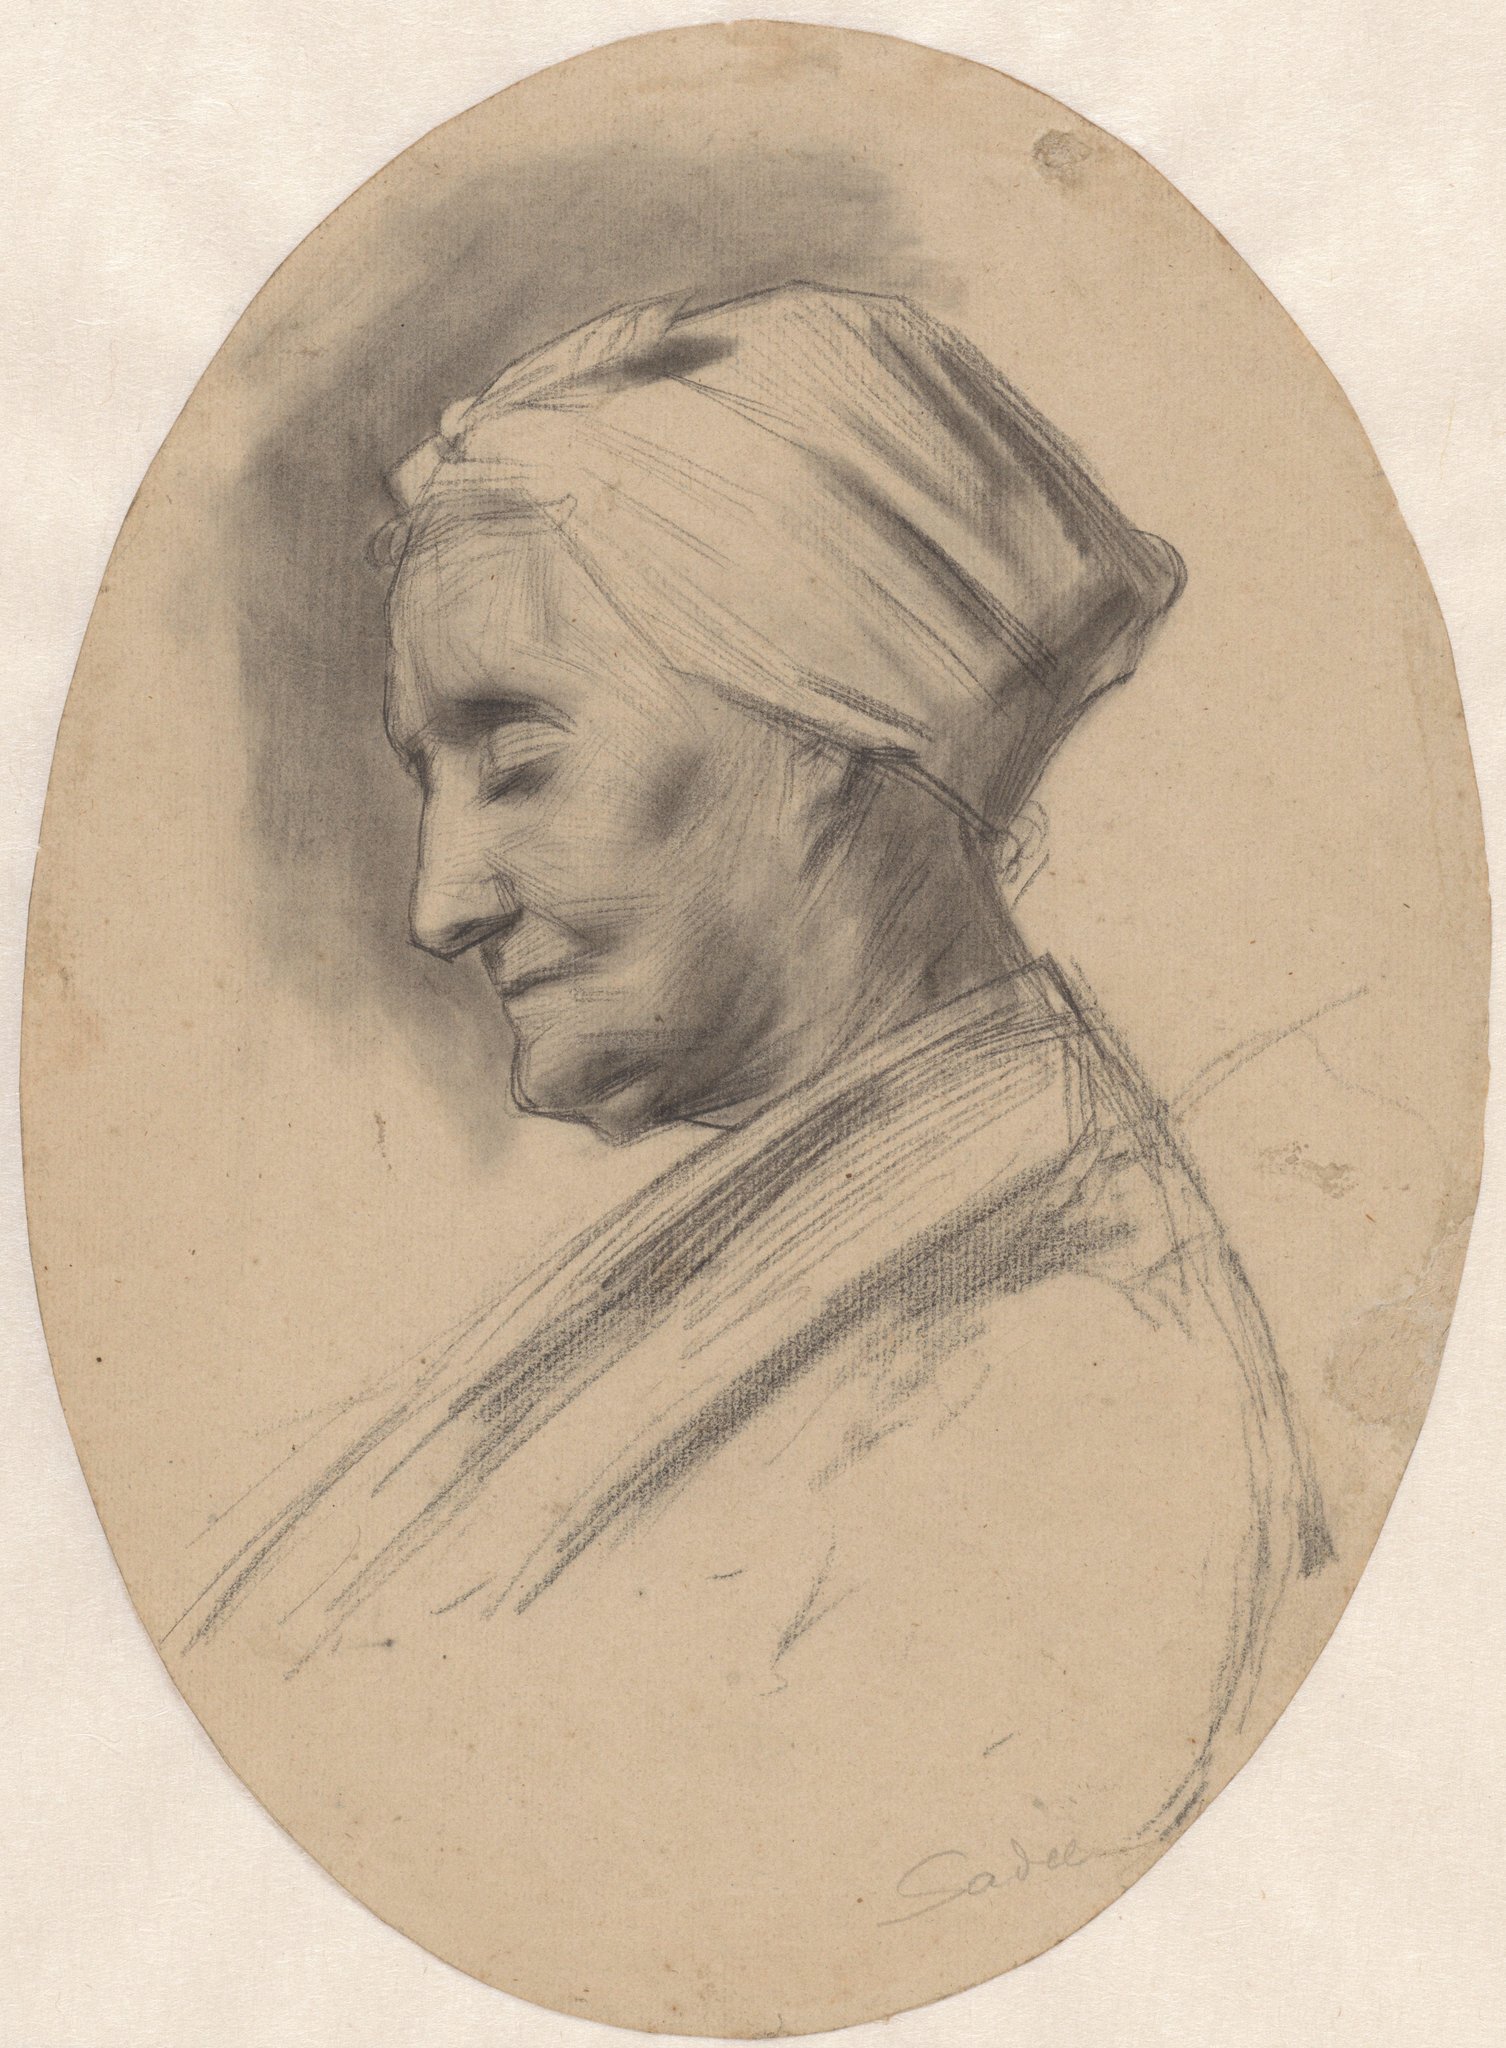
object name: drawing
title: Hoofd van een Scheveningse vrouw, van opzij naar links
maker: philip sadée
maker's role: draughtsman, painter, print maker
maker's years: 1837-1904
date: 1847-1904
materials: chalk, paper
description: Tekening gemaakt door Sadée of door Kever naar Sadée.